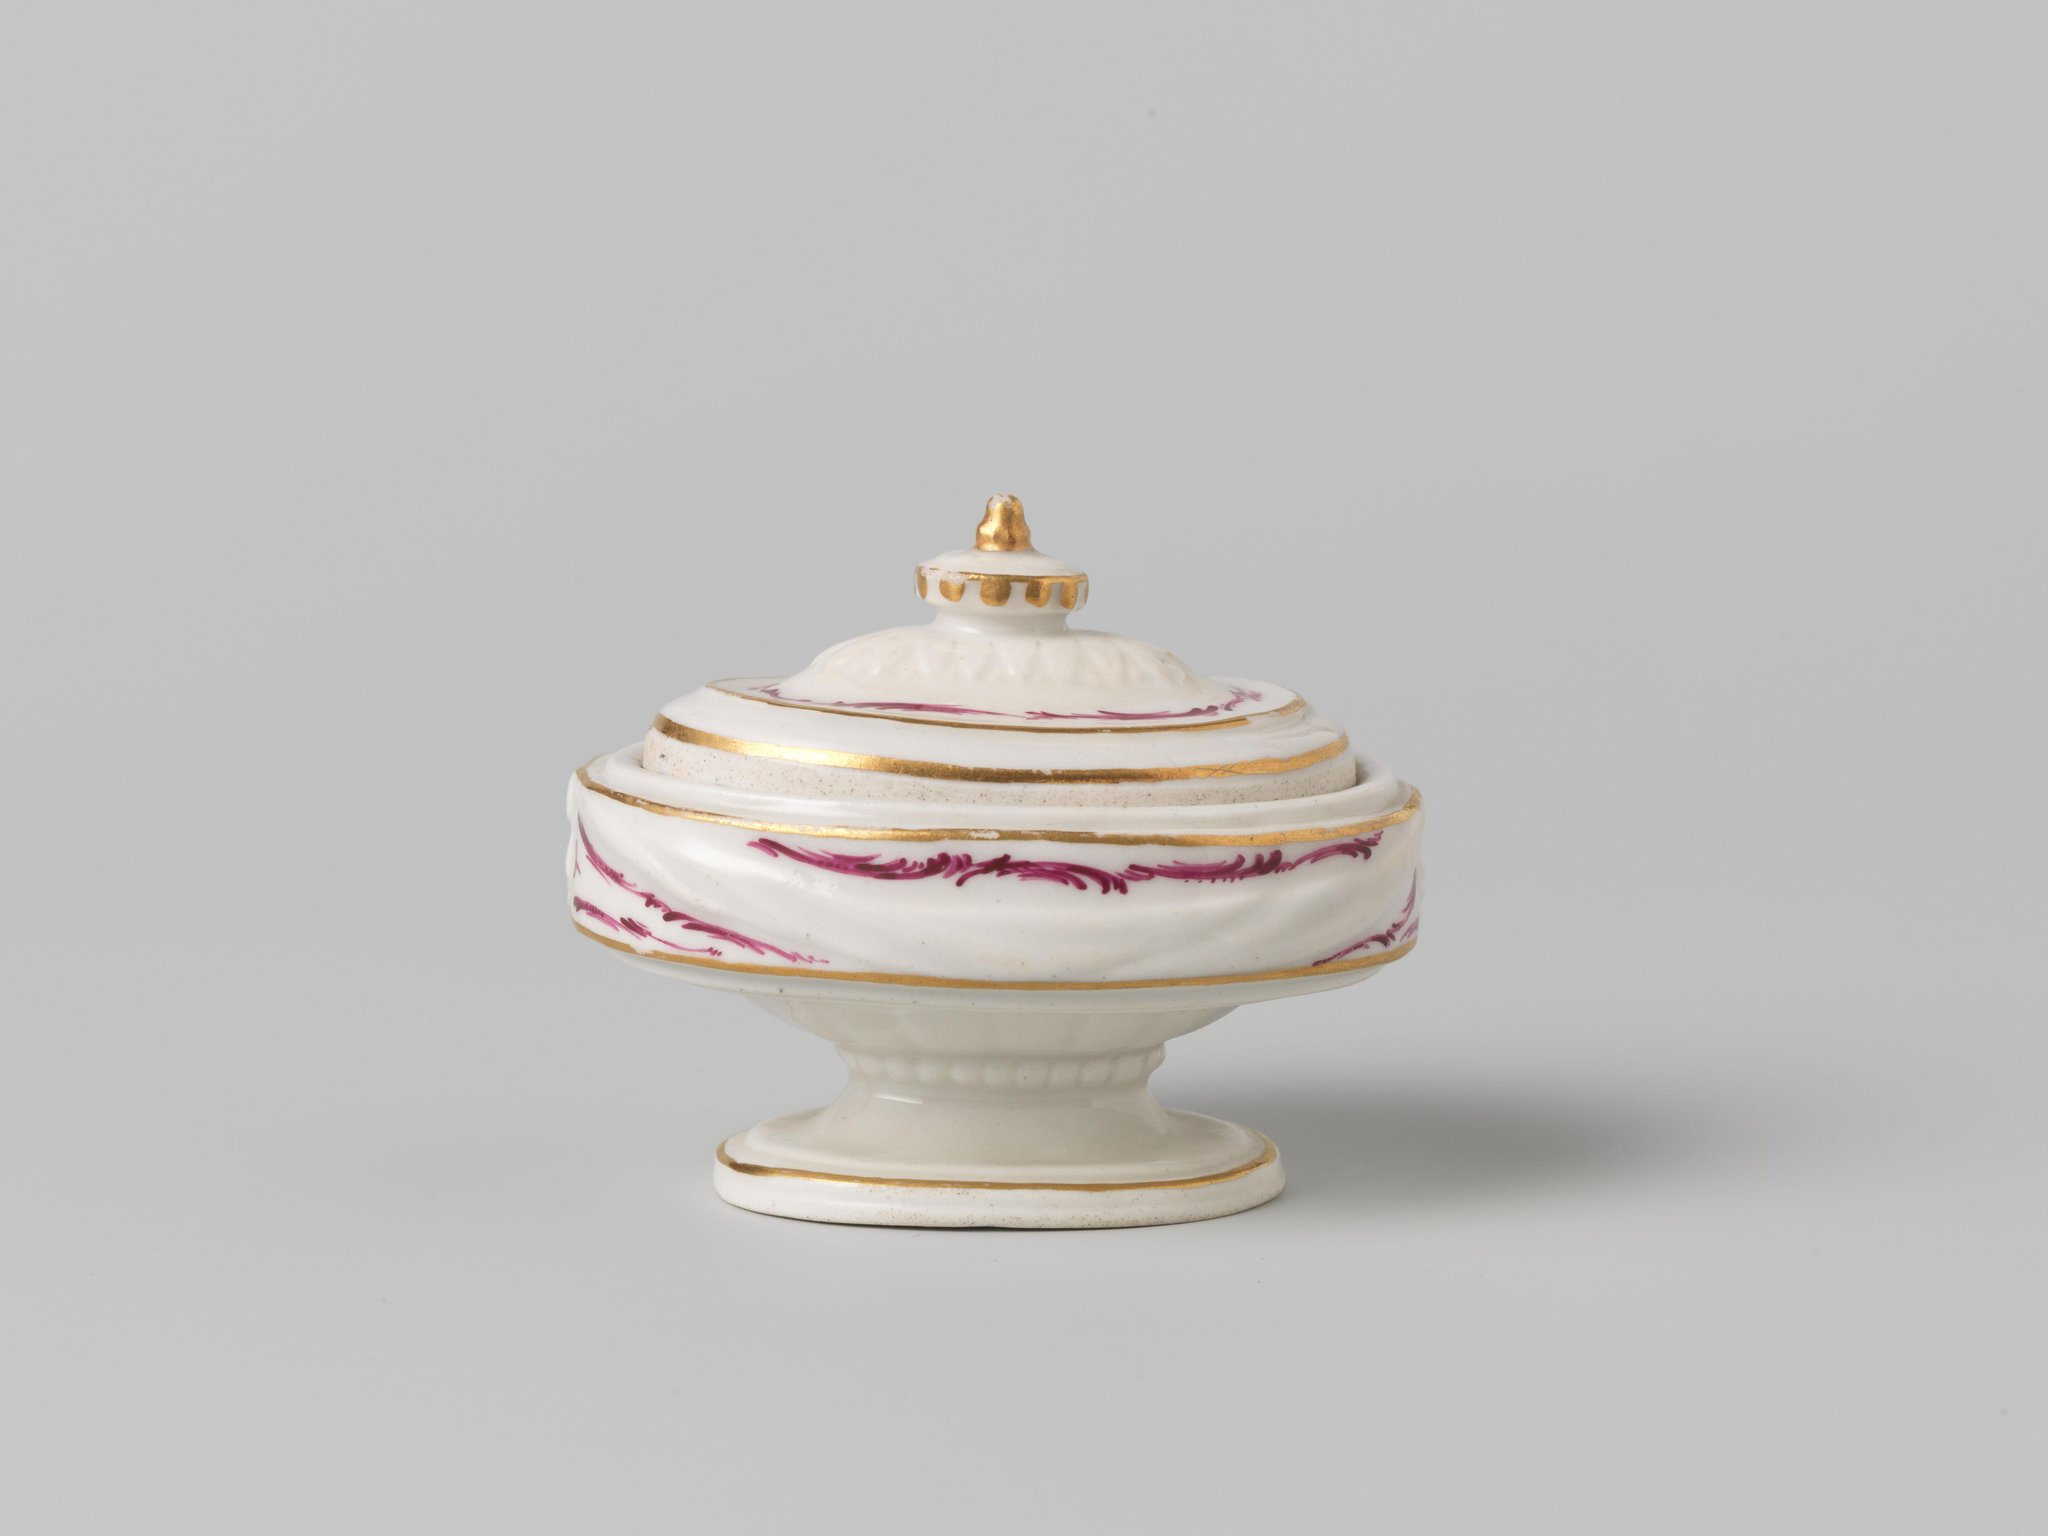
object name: dressing case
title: Toiletdoos met rocailles in reliëf, de binnenzijde beschilderd met figuren in een rivierlandschap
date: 1778-1782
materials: porcelain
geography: loosdrecht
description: Toiletdoos van porselein. Op het lichaam aan knoppen hangende draperieën in reliëf, waaromheen rocailles geschilderd zijn in bietenrood. Gouden biezen.